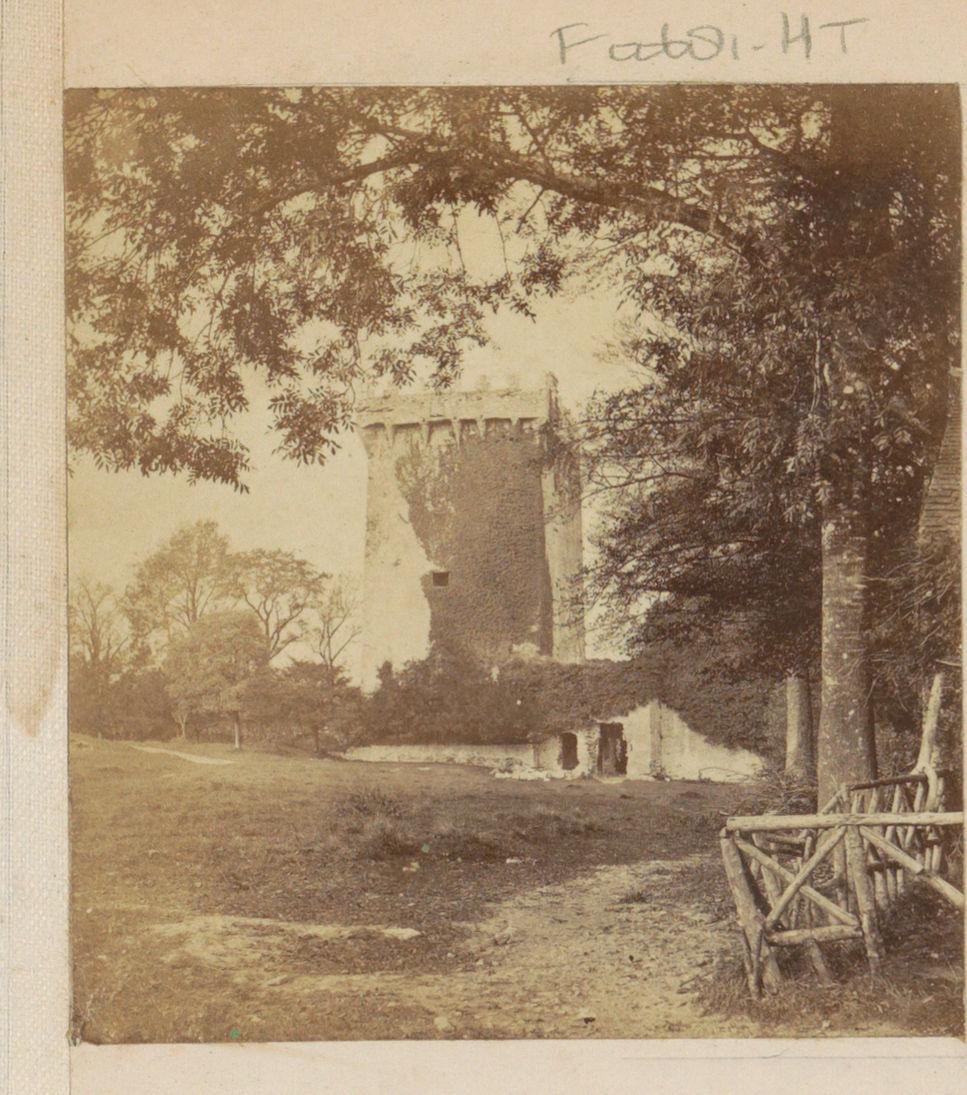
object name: photograph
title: Landschap met een overwoekerde torenruïne in Engeland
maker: Anonymous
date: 1850-1870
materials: paper, photographic support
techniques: albumen print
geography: england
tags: ruin of a dwelling, house, castle, etc., england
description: Onderdeel van Album met foto's van bezienswaardigheden en landschappen in Engeland en van kunst.